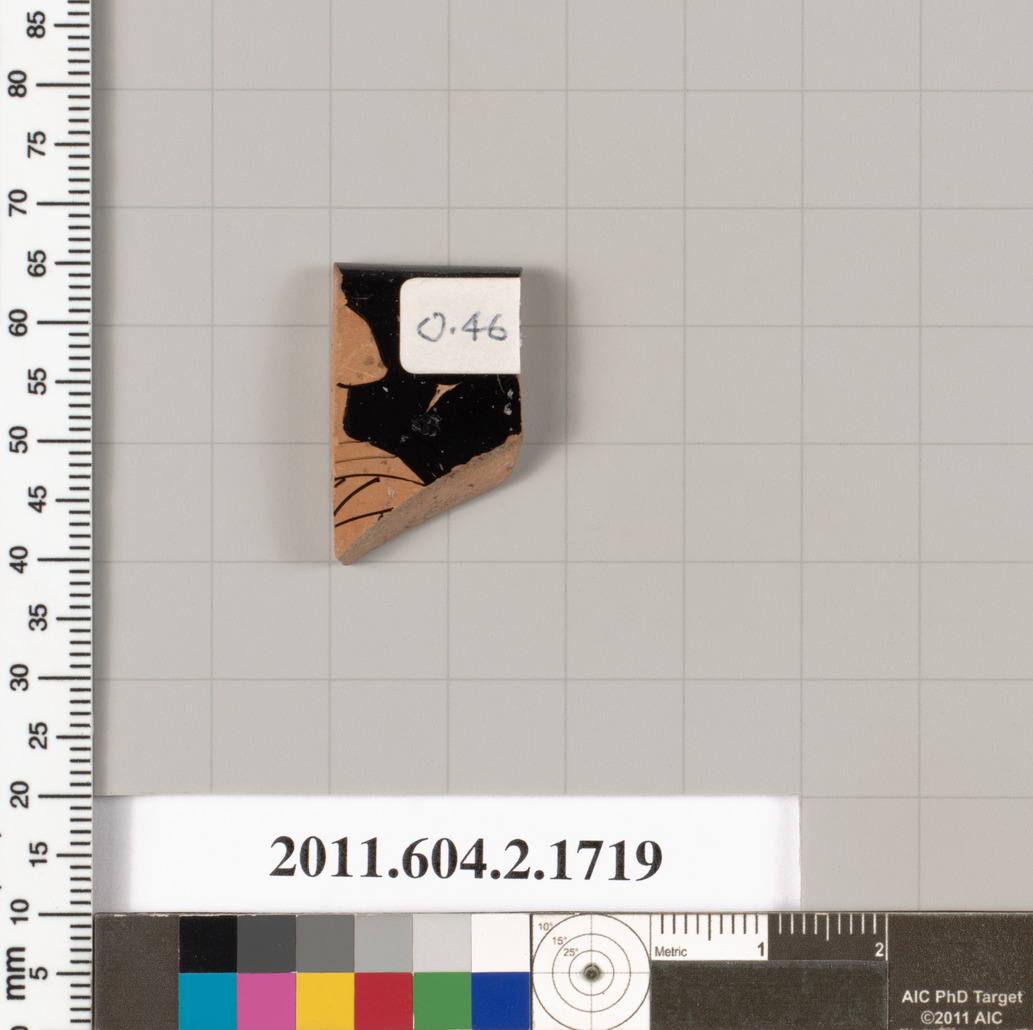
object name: skyphos fragment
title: Terracotta rim fragment of a skyphos (deep drinking cup)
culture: greek, attic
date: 475-451 BCE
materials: terracotta